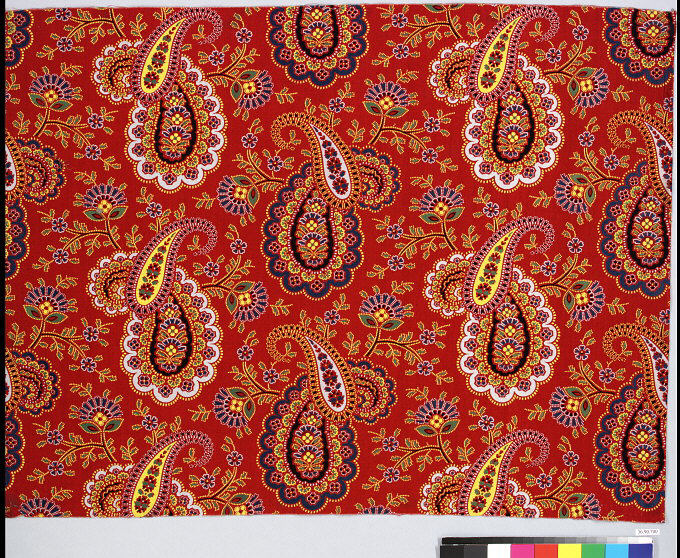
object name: piece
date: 1867-1900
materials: cotton